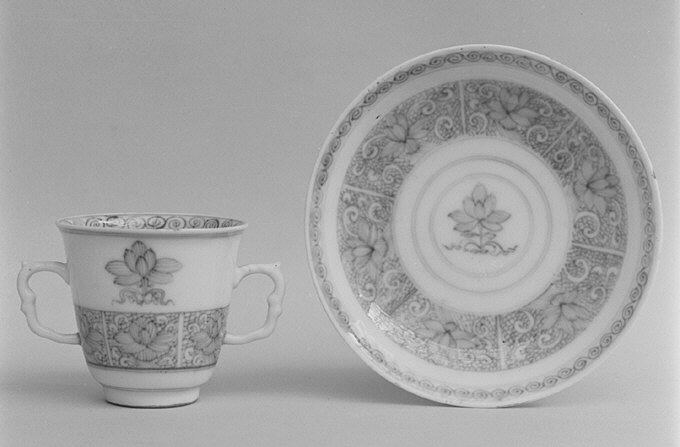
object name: cup and saucer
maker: meissen manufactory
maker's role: manufactory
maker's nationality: german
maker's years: 1710-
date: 1740-1745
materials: hard paste porcelain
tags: flowers